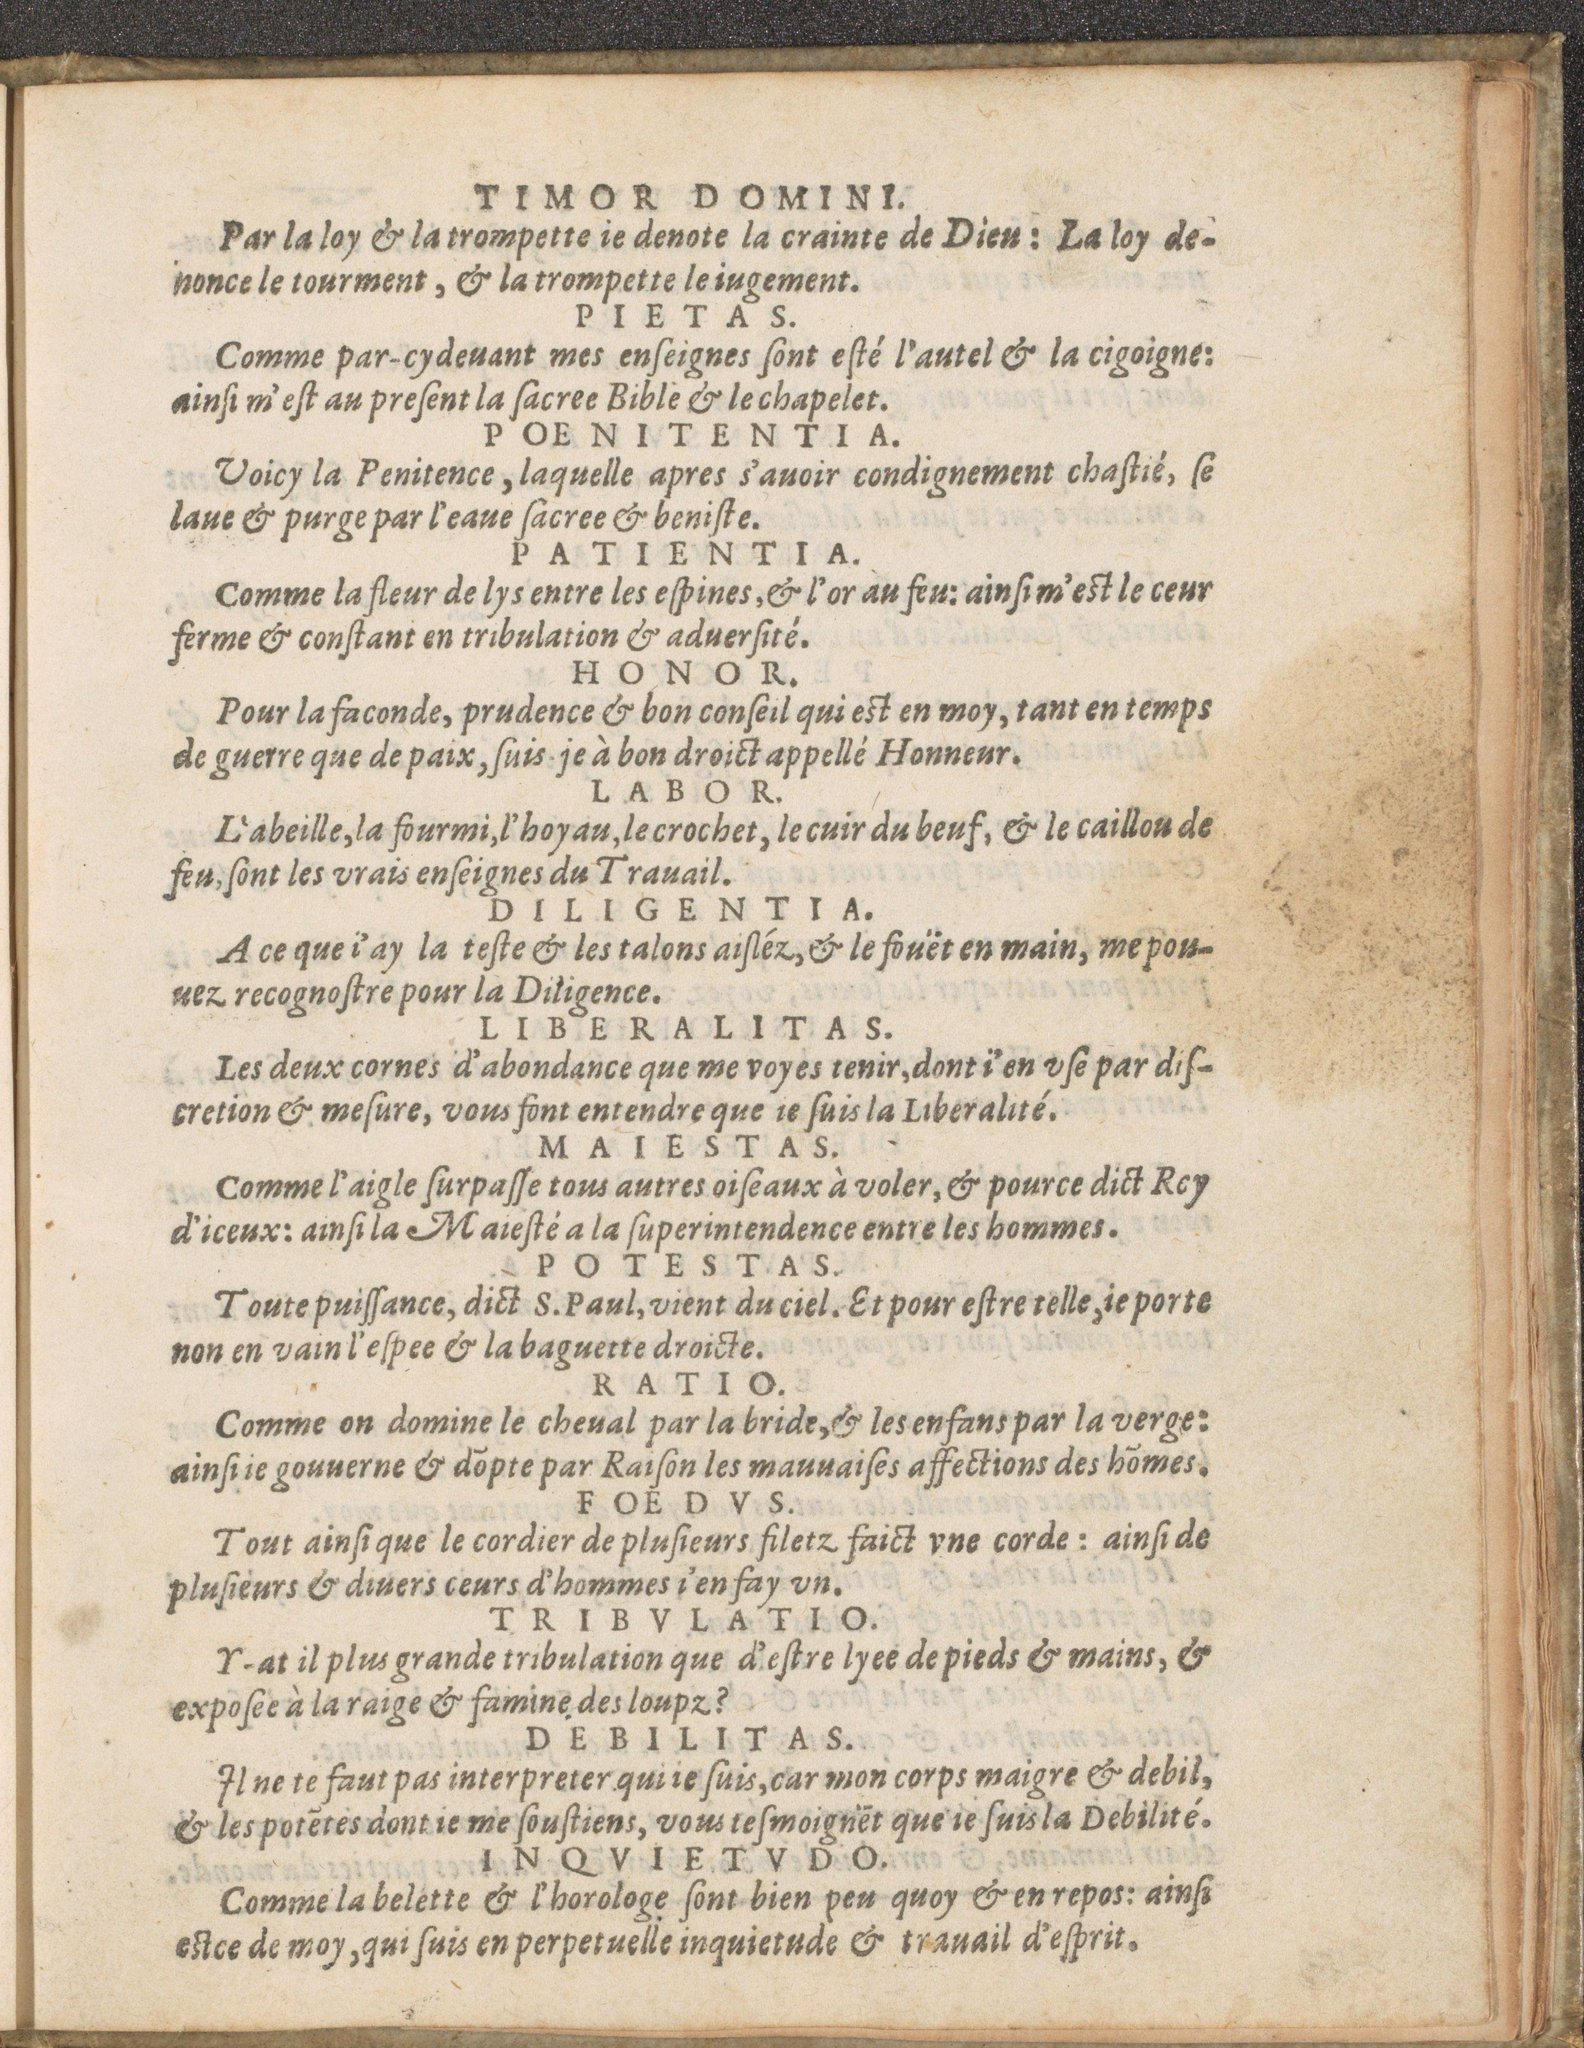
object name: text sheet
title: Franstalige uitleg bij de voorstellingen, pagina 2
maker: philips galle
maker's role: print maker, publisher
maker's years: 1537-1612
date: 1585-1590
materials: paper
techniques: letterpress printing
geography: antwerp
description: Franstalige uitleg bij de voorstellingen in drie pagina's: pagina 2. Het blad maakt deel uit van een album.